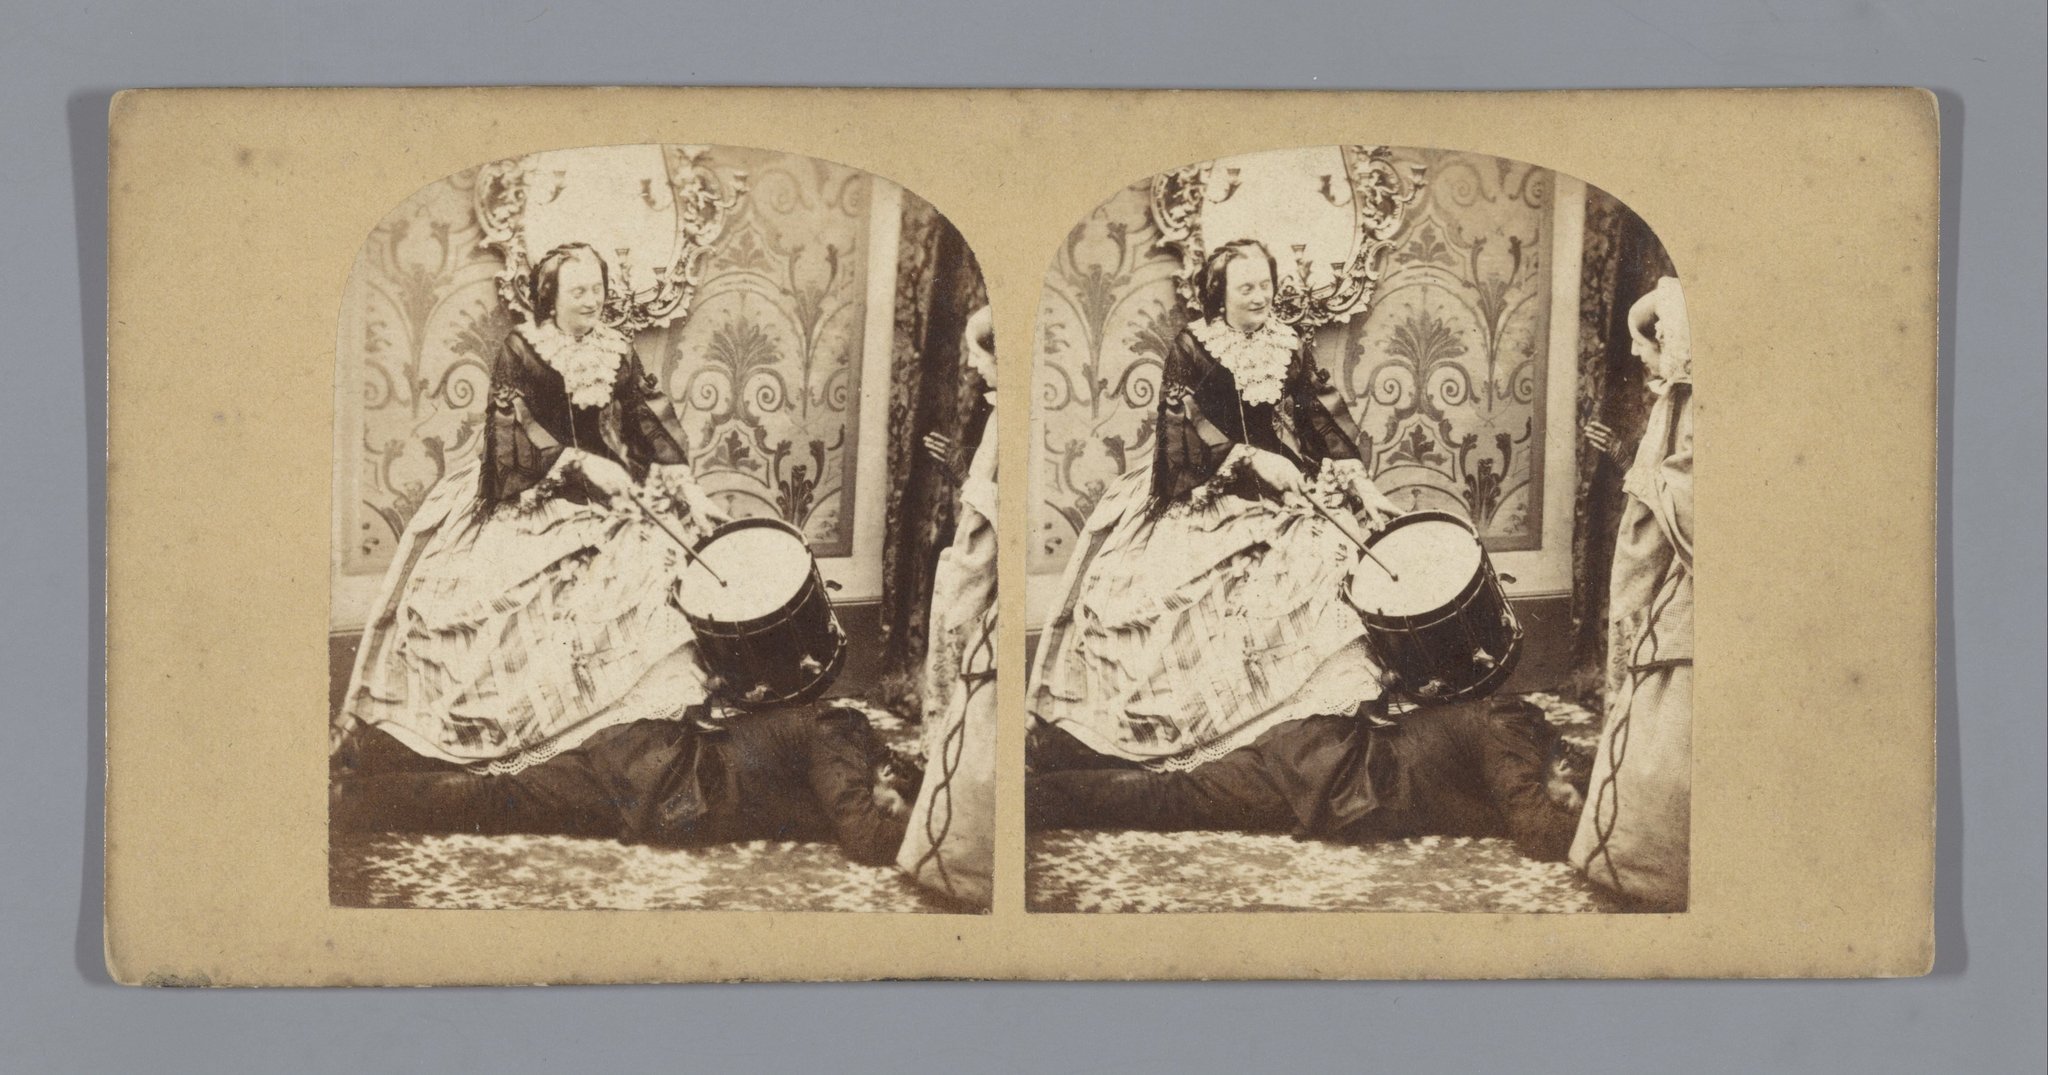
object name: stereograph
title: Vrouw met een trommel staat met een voet op een liggende man, een andere vrouw kijkt toe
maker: Anonymous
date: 1850-1880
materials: cardboard, photographic support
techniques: albumen print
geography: europe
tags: drum (musical instrument), europe